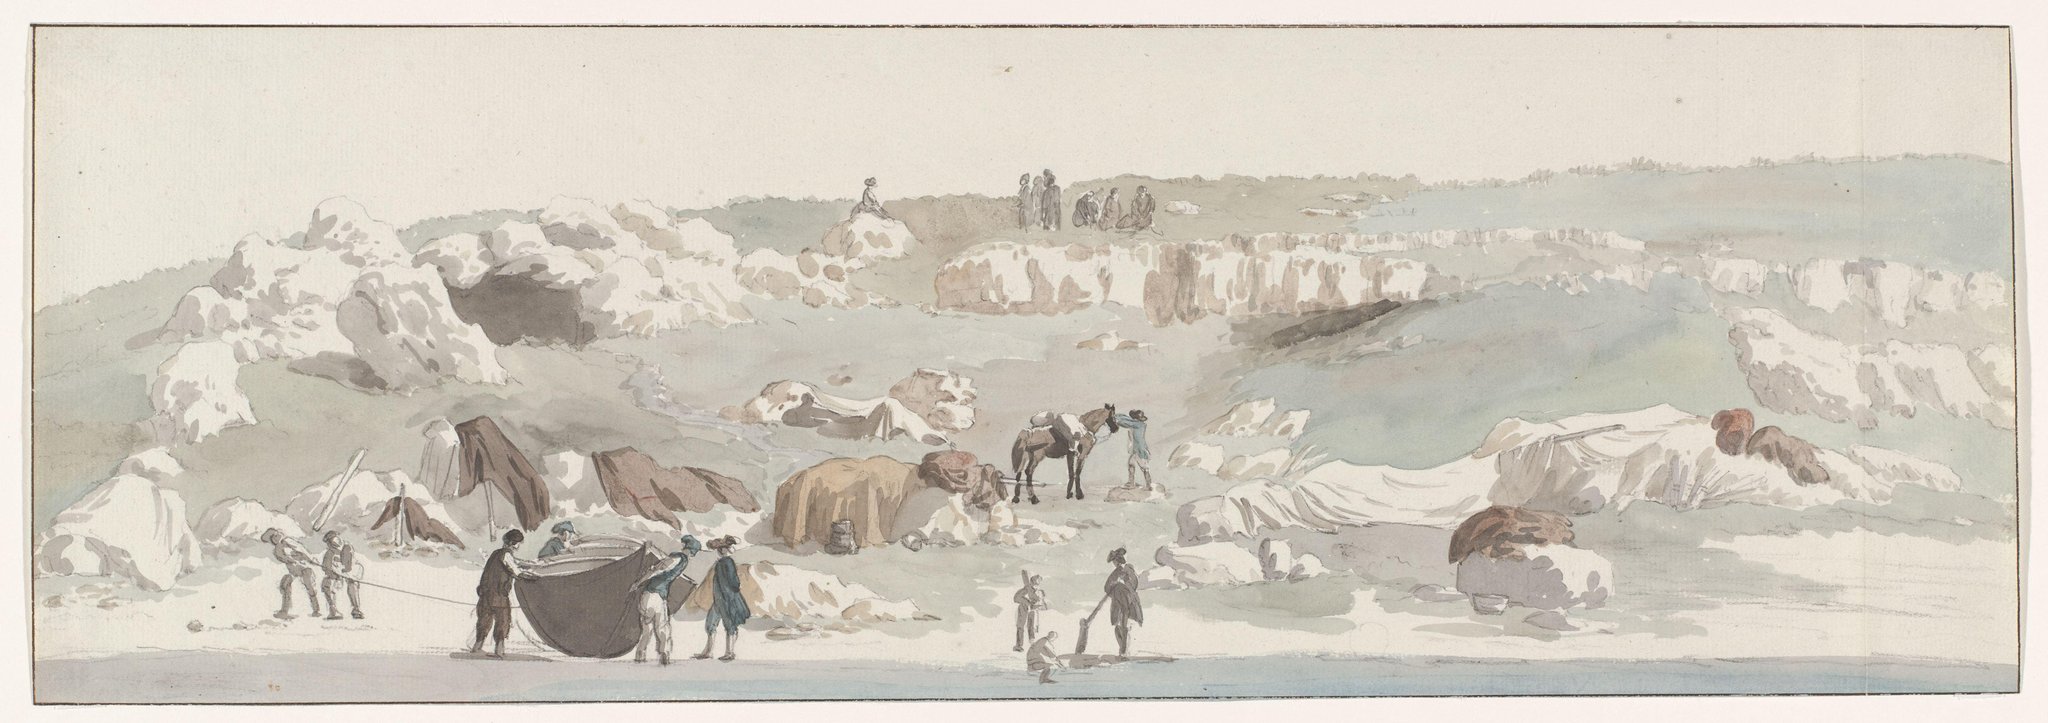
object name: drawing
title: Voyage en Italie, en Sicile et à Malte - 1778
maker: louis ducros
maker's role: draughtsman, print maker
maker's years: 1748-1810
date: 1778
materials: chalk, paper, watercolor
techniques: brush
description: Tekening uit het album 'Voyage en Italie, en Sicile et à Malte', 1778.